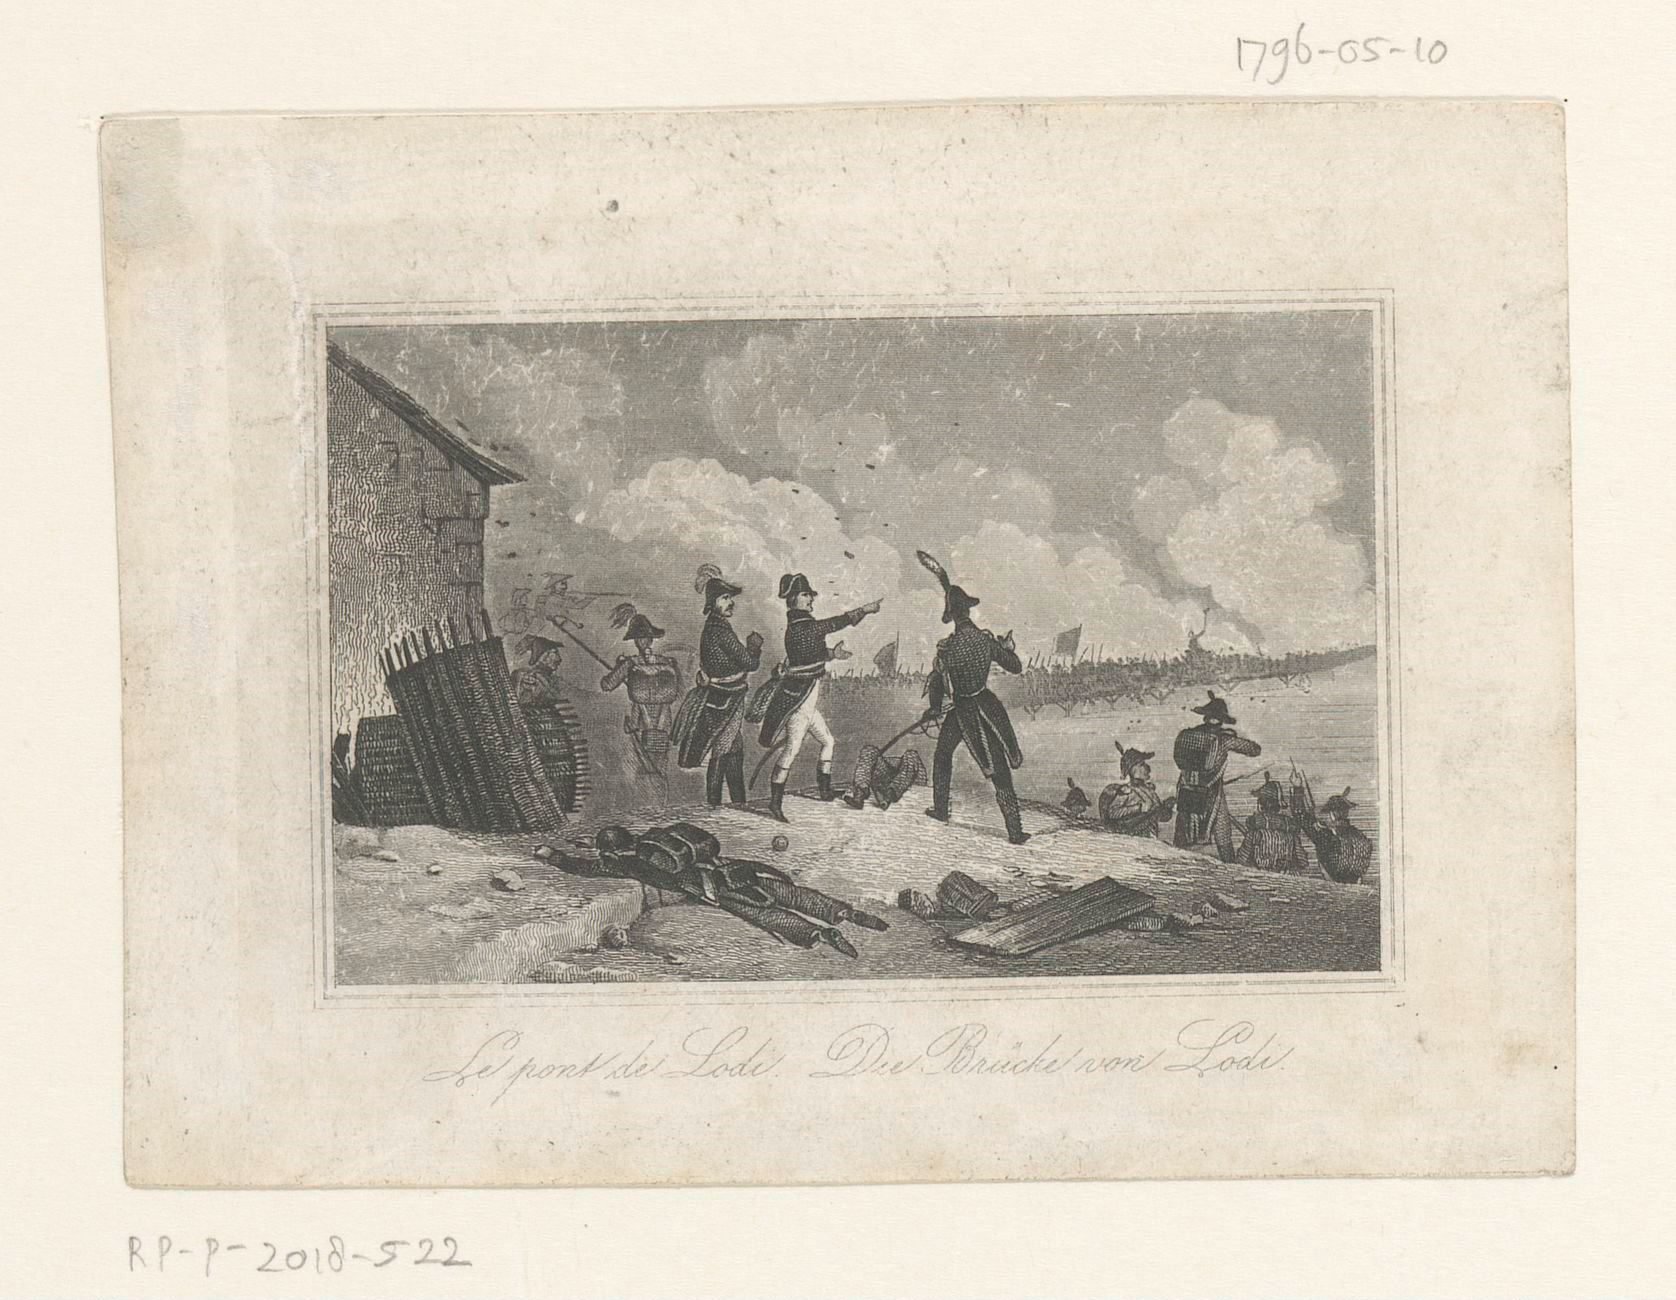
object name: print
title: Leger van Napoleon steekt de Lodi over, 1796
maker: Anonymous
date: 1821-1899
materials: paper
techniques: engraving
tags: napoleon i (emperor of the french), army 'en route'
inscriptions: collector's mark: Lugt 2228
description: Het leger van Napoleon steekt de Lodi over, 10 mei 1796. Onder de voorstelling de titels in het Frans en Duits. Onderdeel van een groep van twaalf illustraties.